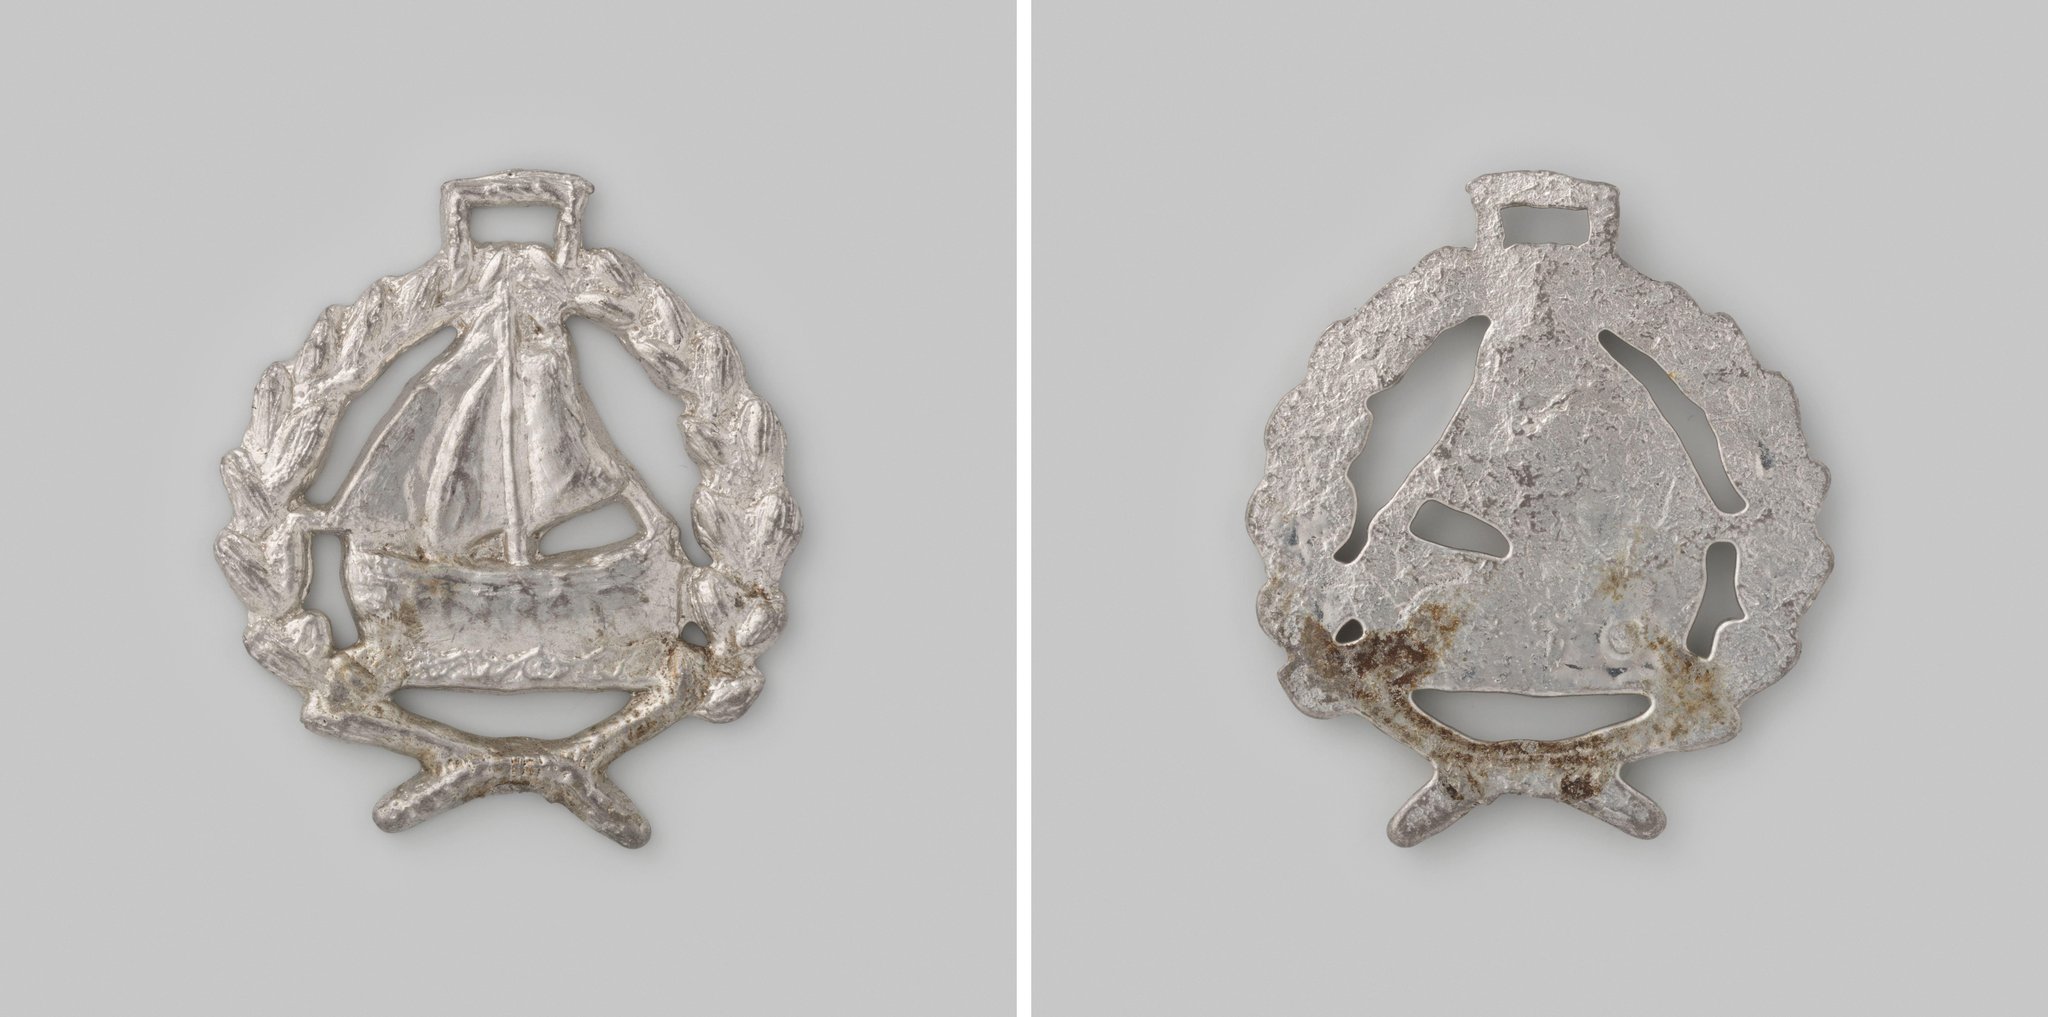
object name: insignia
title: Draagteken vissersboot in krans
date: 1800-1900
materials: tin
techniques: casting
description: Gegoten tinnen draagteken met rechthoekig draagoog, voorstellend een vissersboot tussen takken met opengewerkt veld.